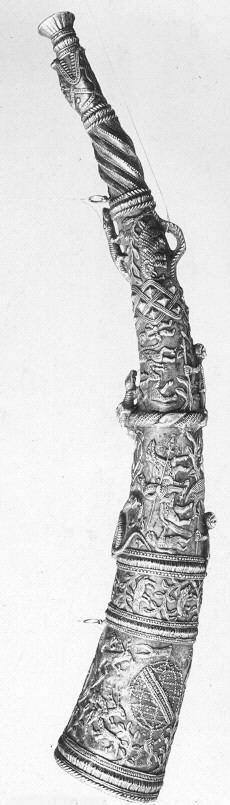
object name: horn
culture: french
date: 1801-1900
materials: copper, silver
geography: france